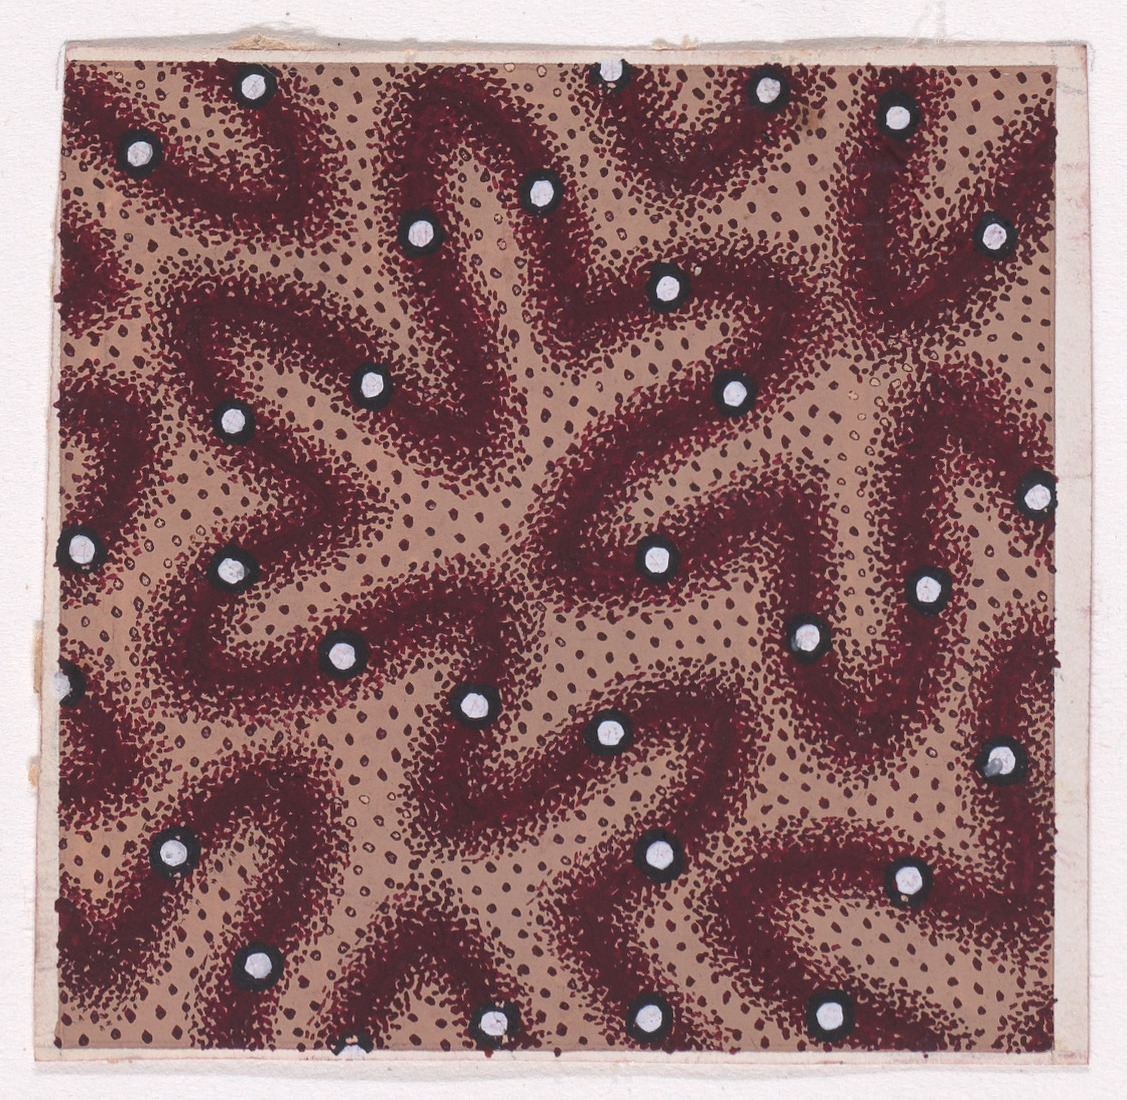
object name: drawing ornament architecture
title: Textile Design with a Vermicular Pattern and Pearls over a Dotted Background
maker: anonymous, alsatian, 19th century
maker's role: artist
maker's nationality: alsatian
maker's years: 1800-1900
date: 1840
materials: gouache